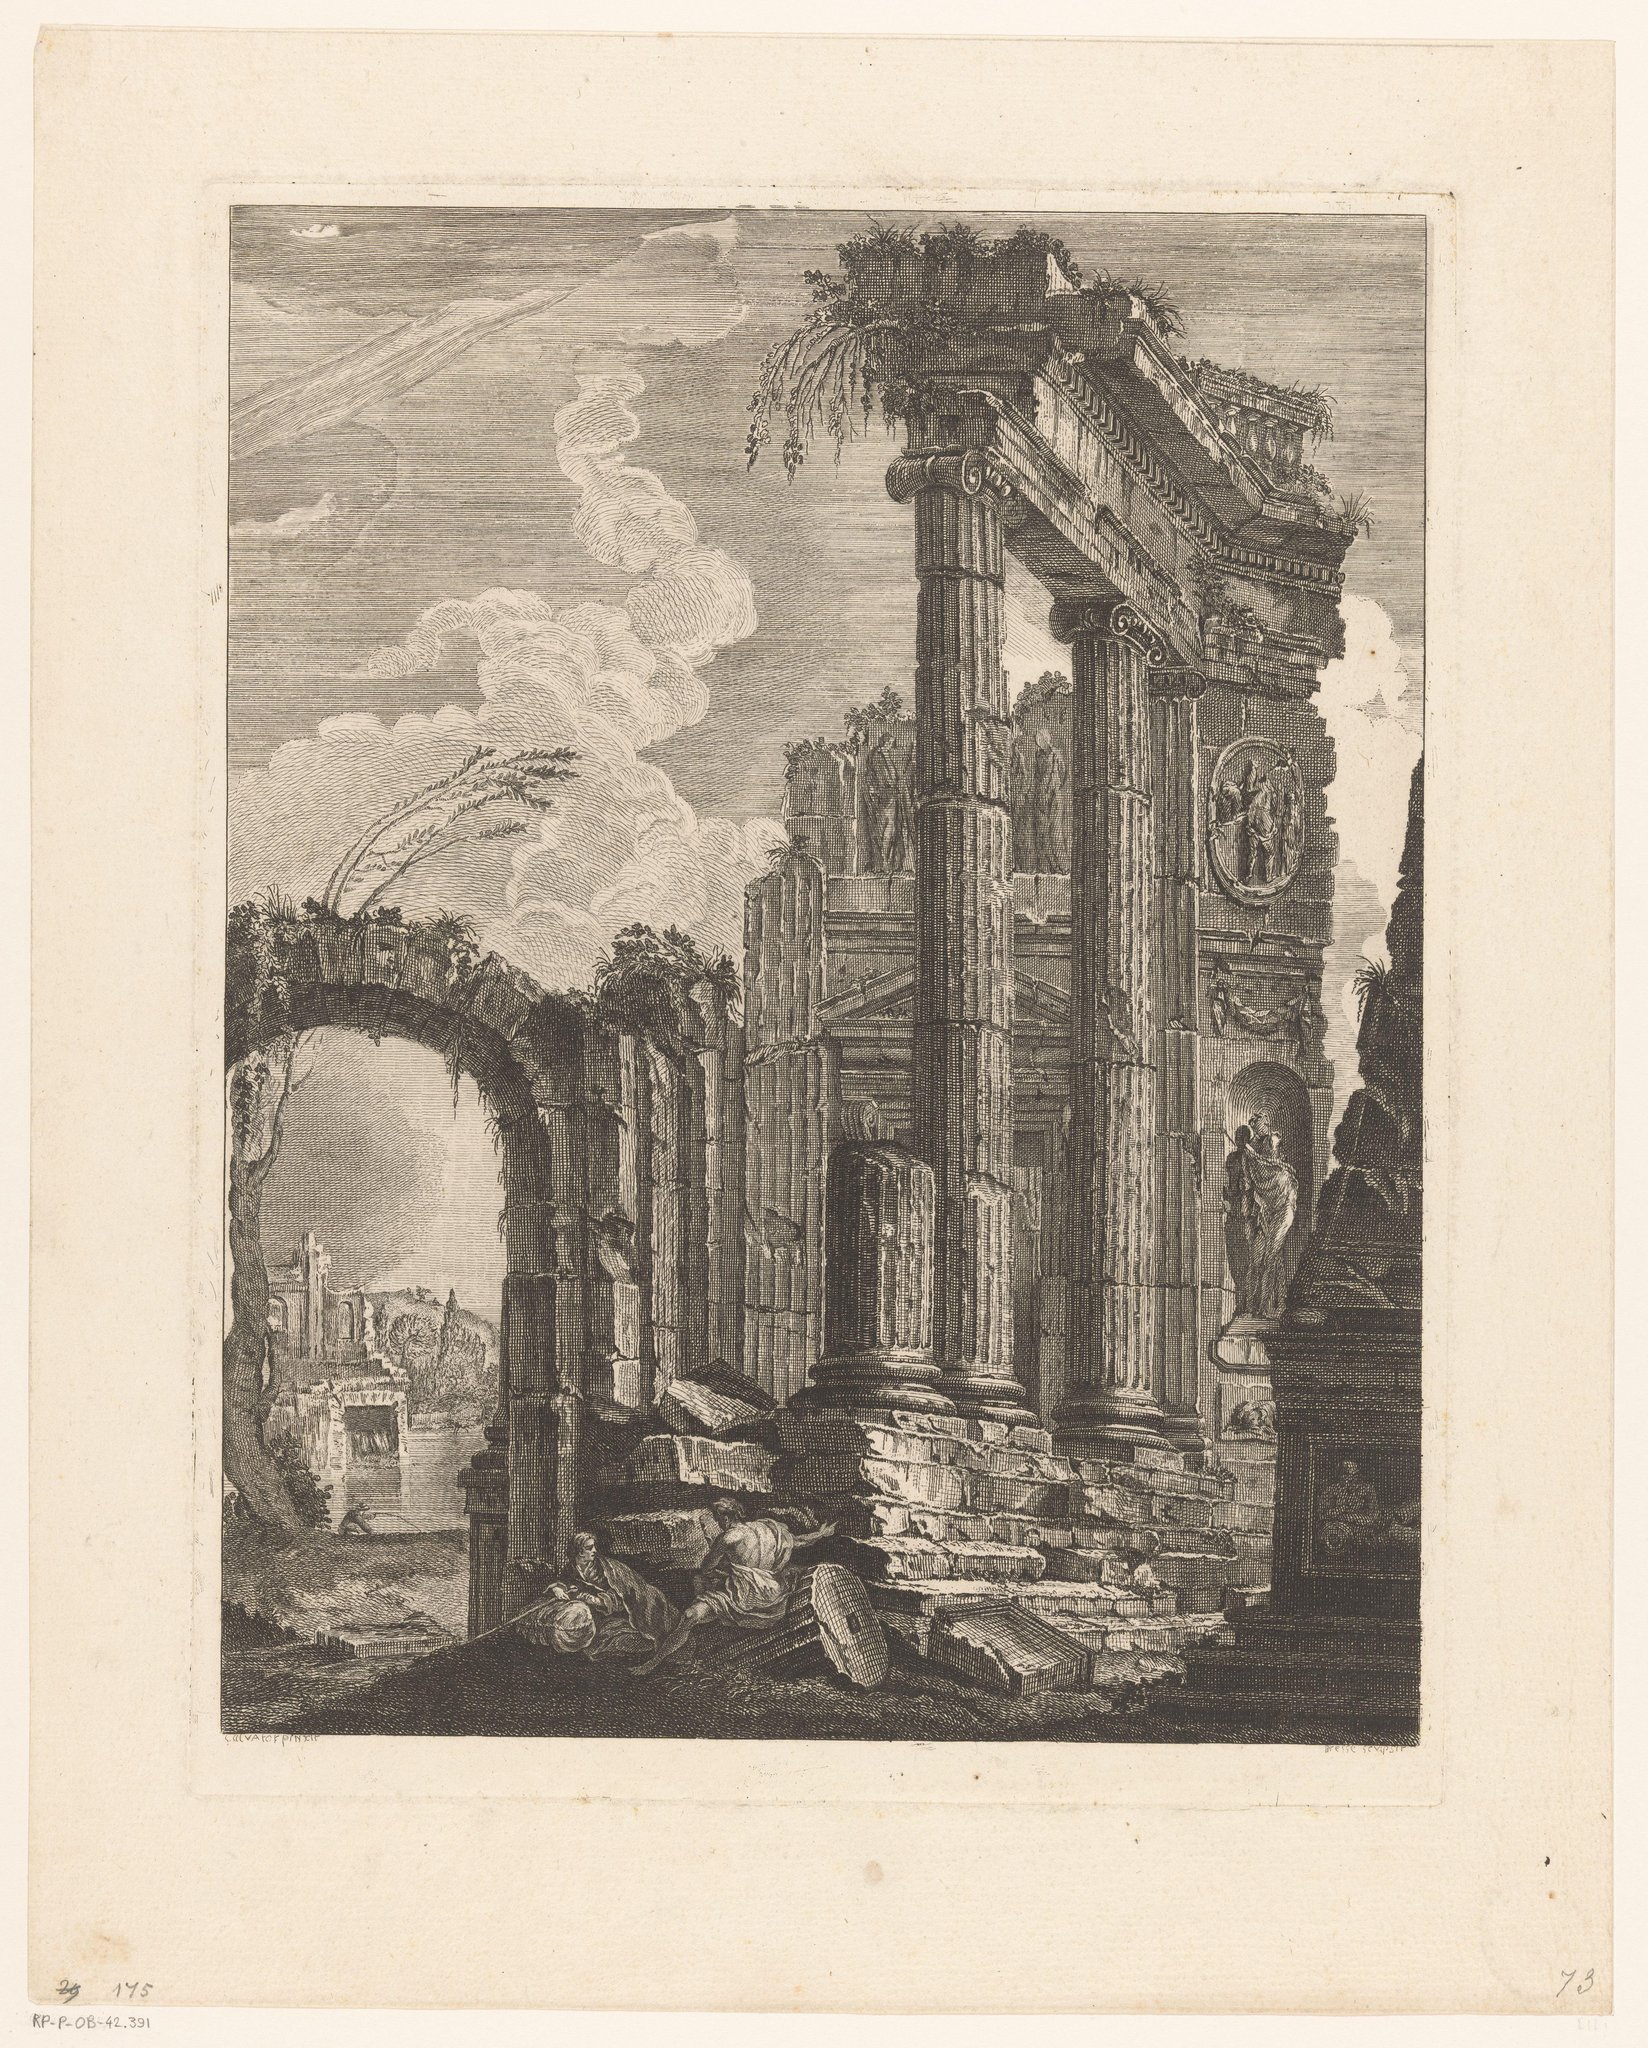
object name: print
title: Twee figuren in een tempelruïne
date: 1700-1799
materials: paper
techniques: engraving, etching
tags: ruin of a building ~ architecture, landscape with ruins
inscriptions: collector's mark: Lugt 240